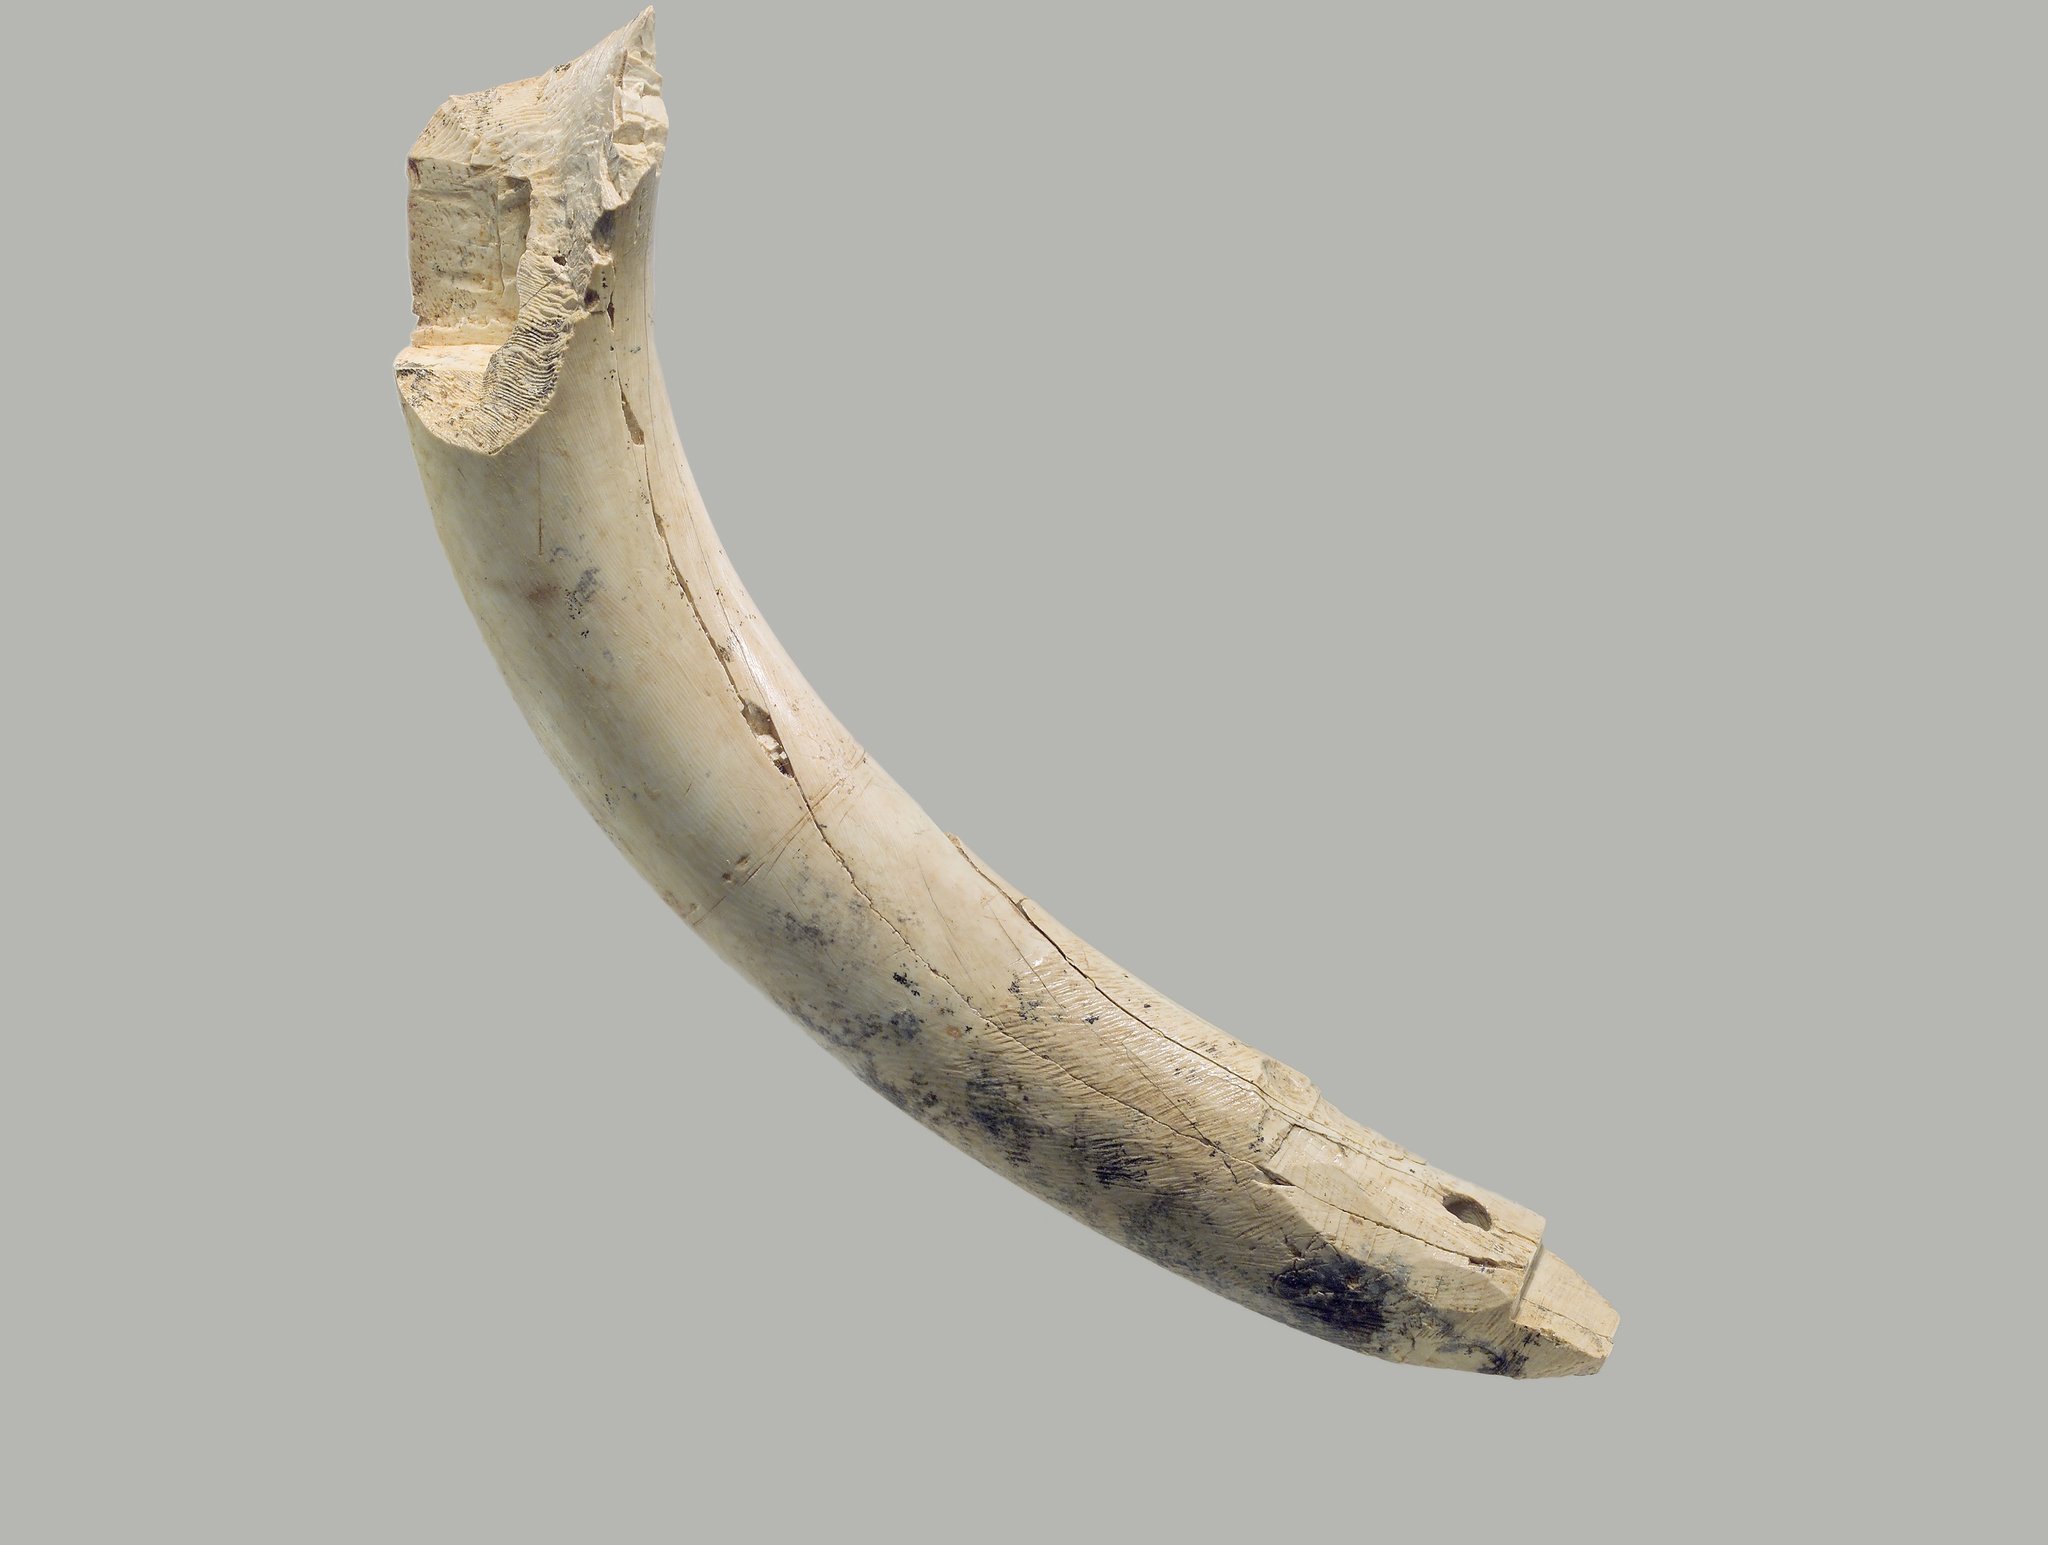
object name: furniture element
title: Furniture element made from a hippopotamus incisor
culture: assyrian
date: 900-701 BCE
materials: ivory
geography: mesopotamia